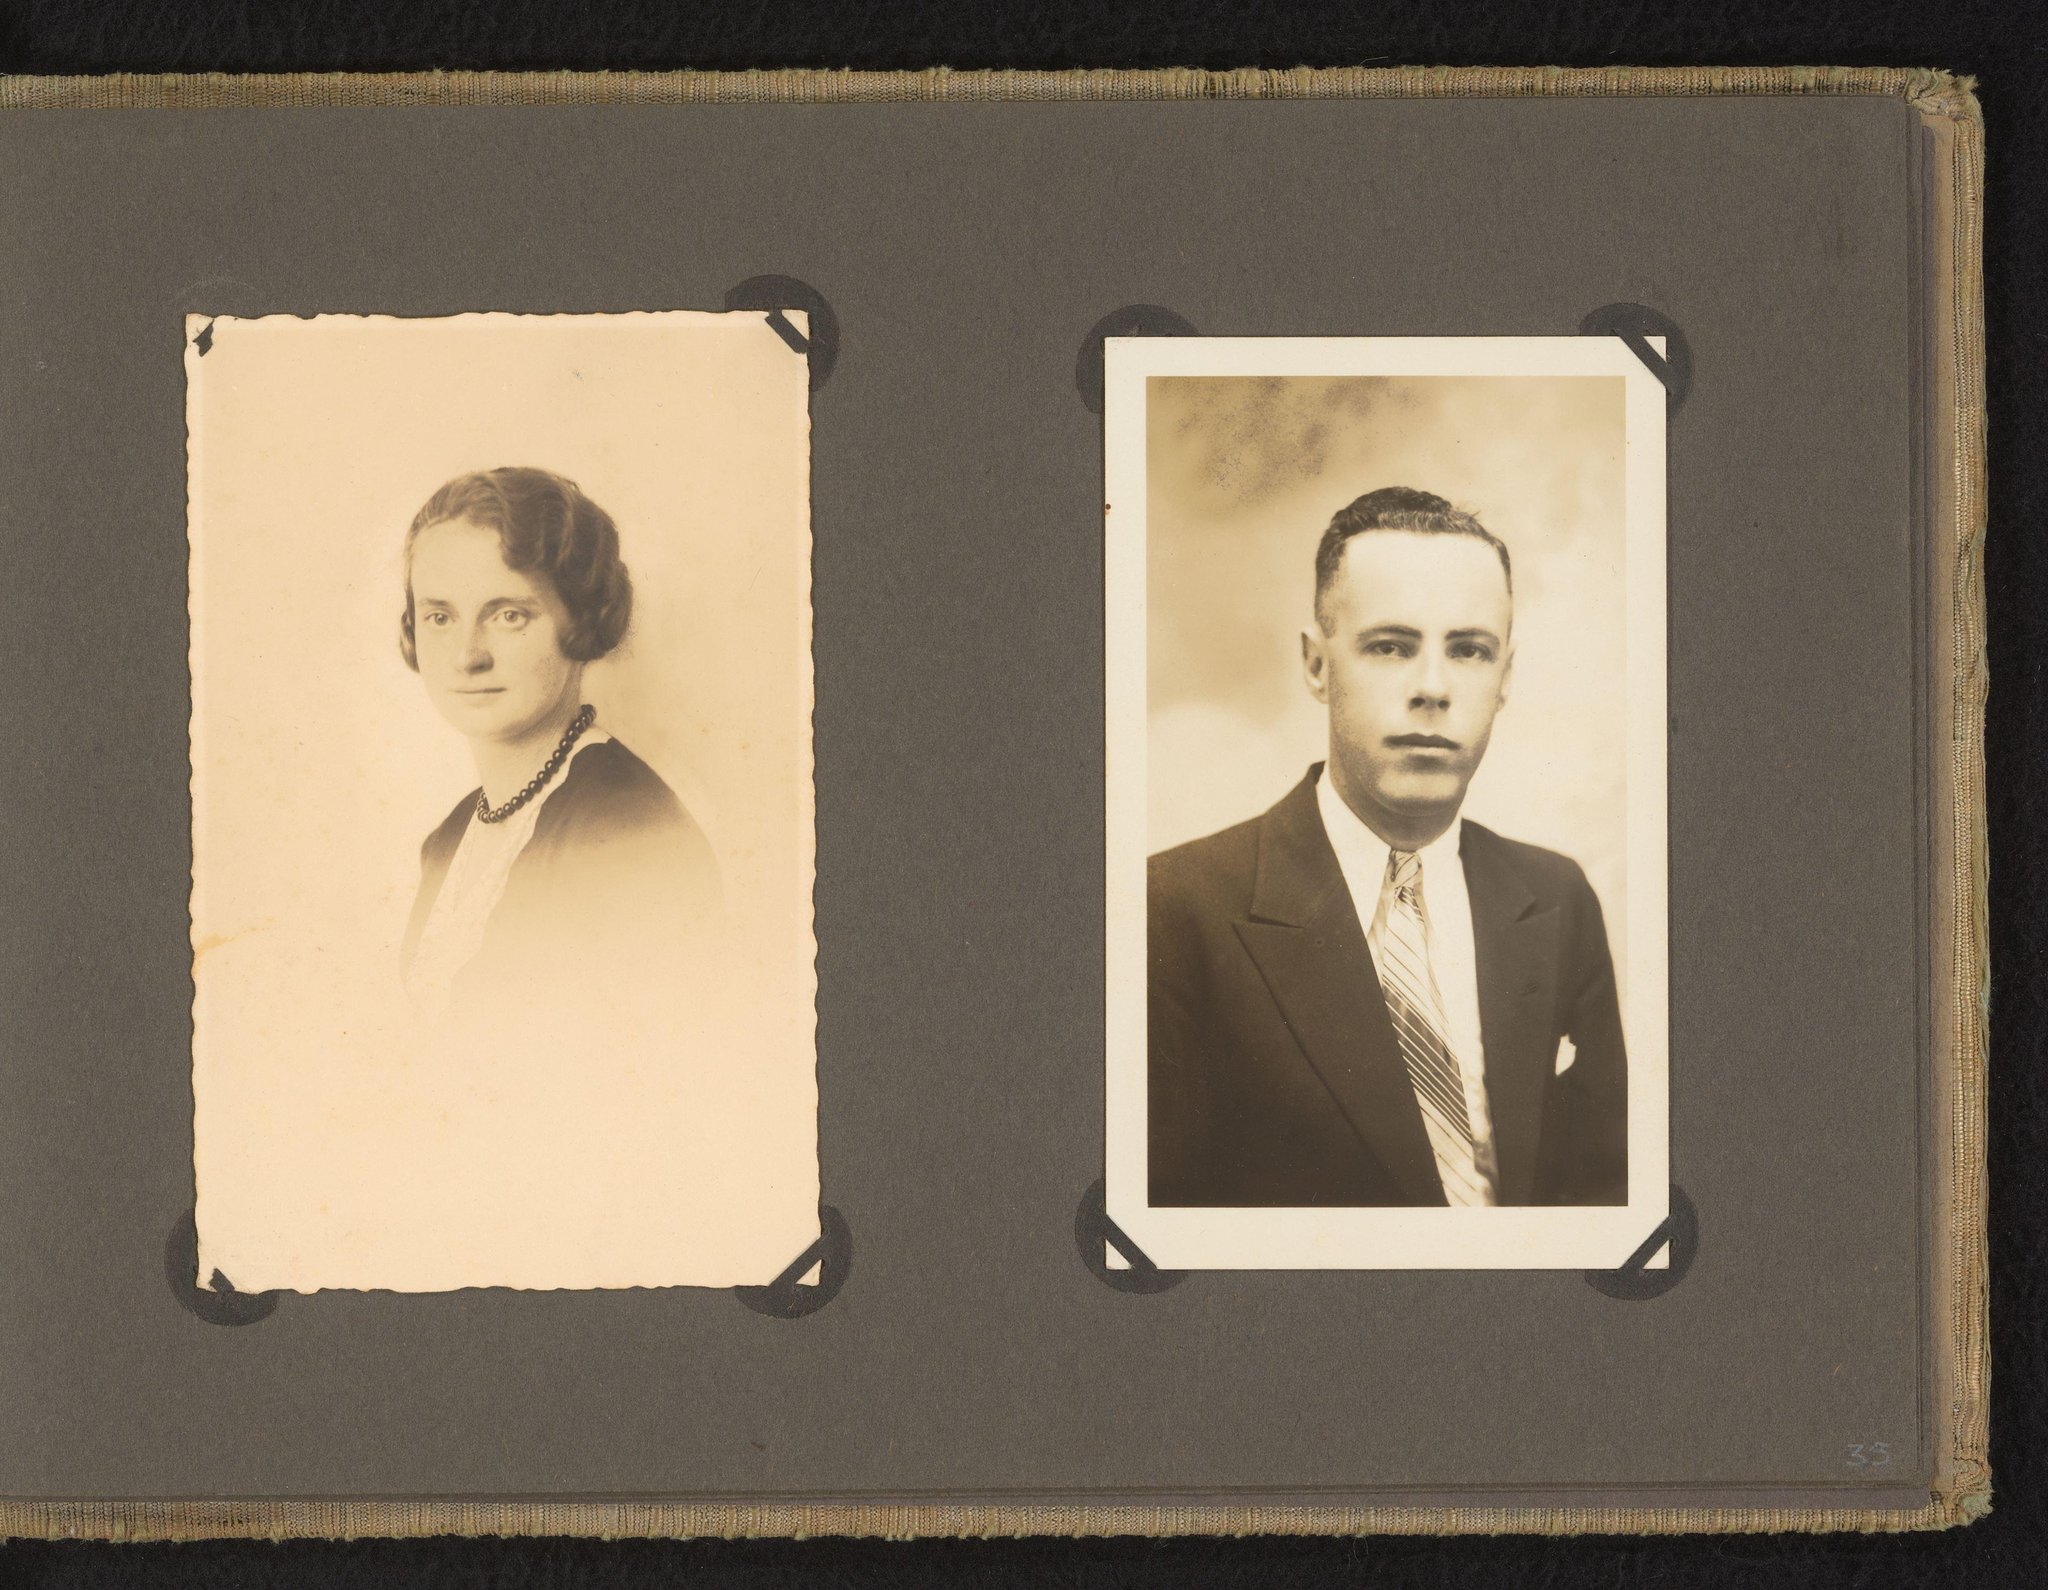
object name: album leaf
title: Twee portretten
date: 1930-1931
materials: cardboard, photographic support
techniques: gelatin silver print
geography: the hague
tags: historical persons not known by name - bb - woman, historical persons not known by name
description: Albumblad met twee foto's, portret van een jonge vrouw (waarschijnlijk de samensteller van het album) en portret van een jonge man. Onderdeel van fotoalbum 'Studentenalbum Indologen'.